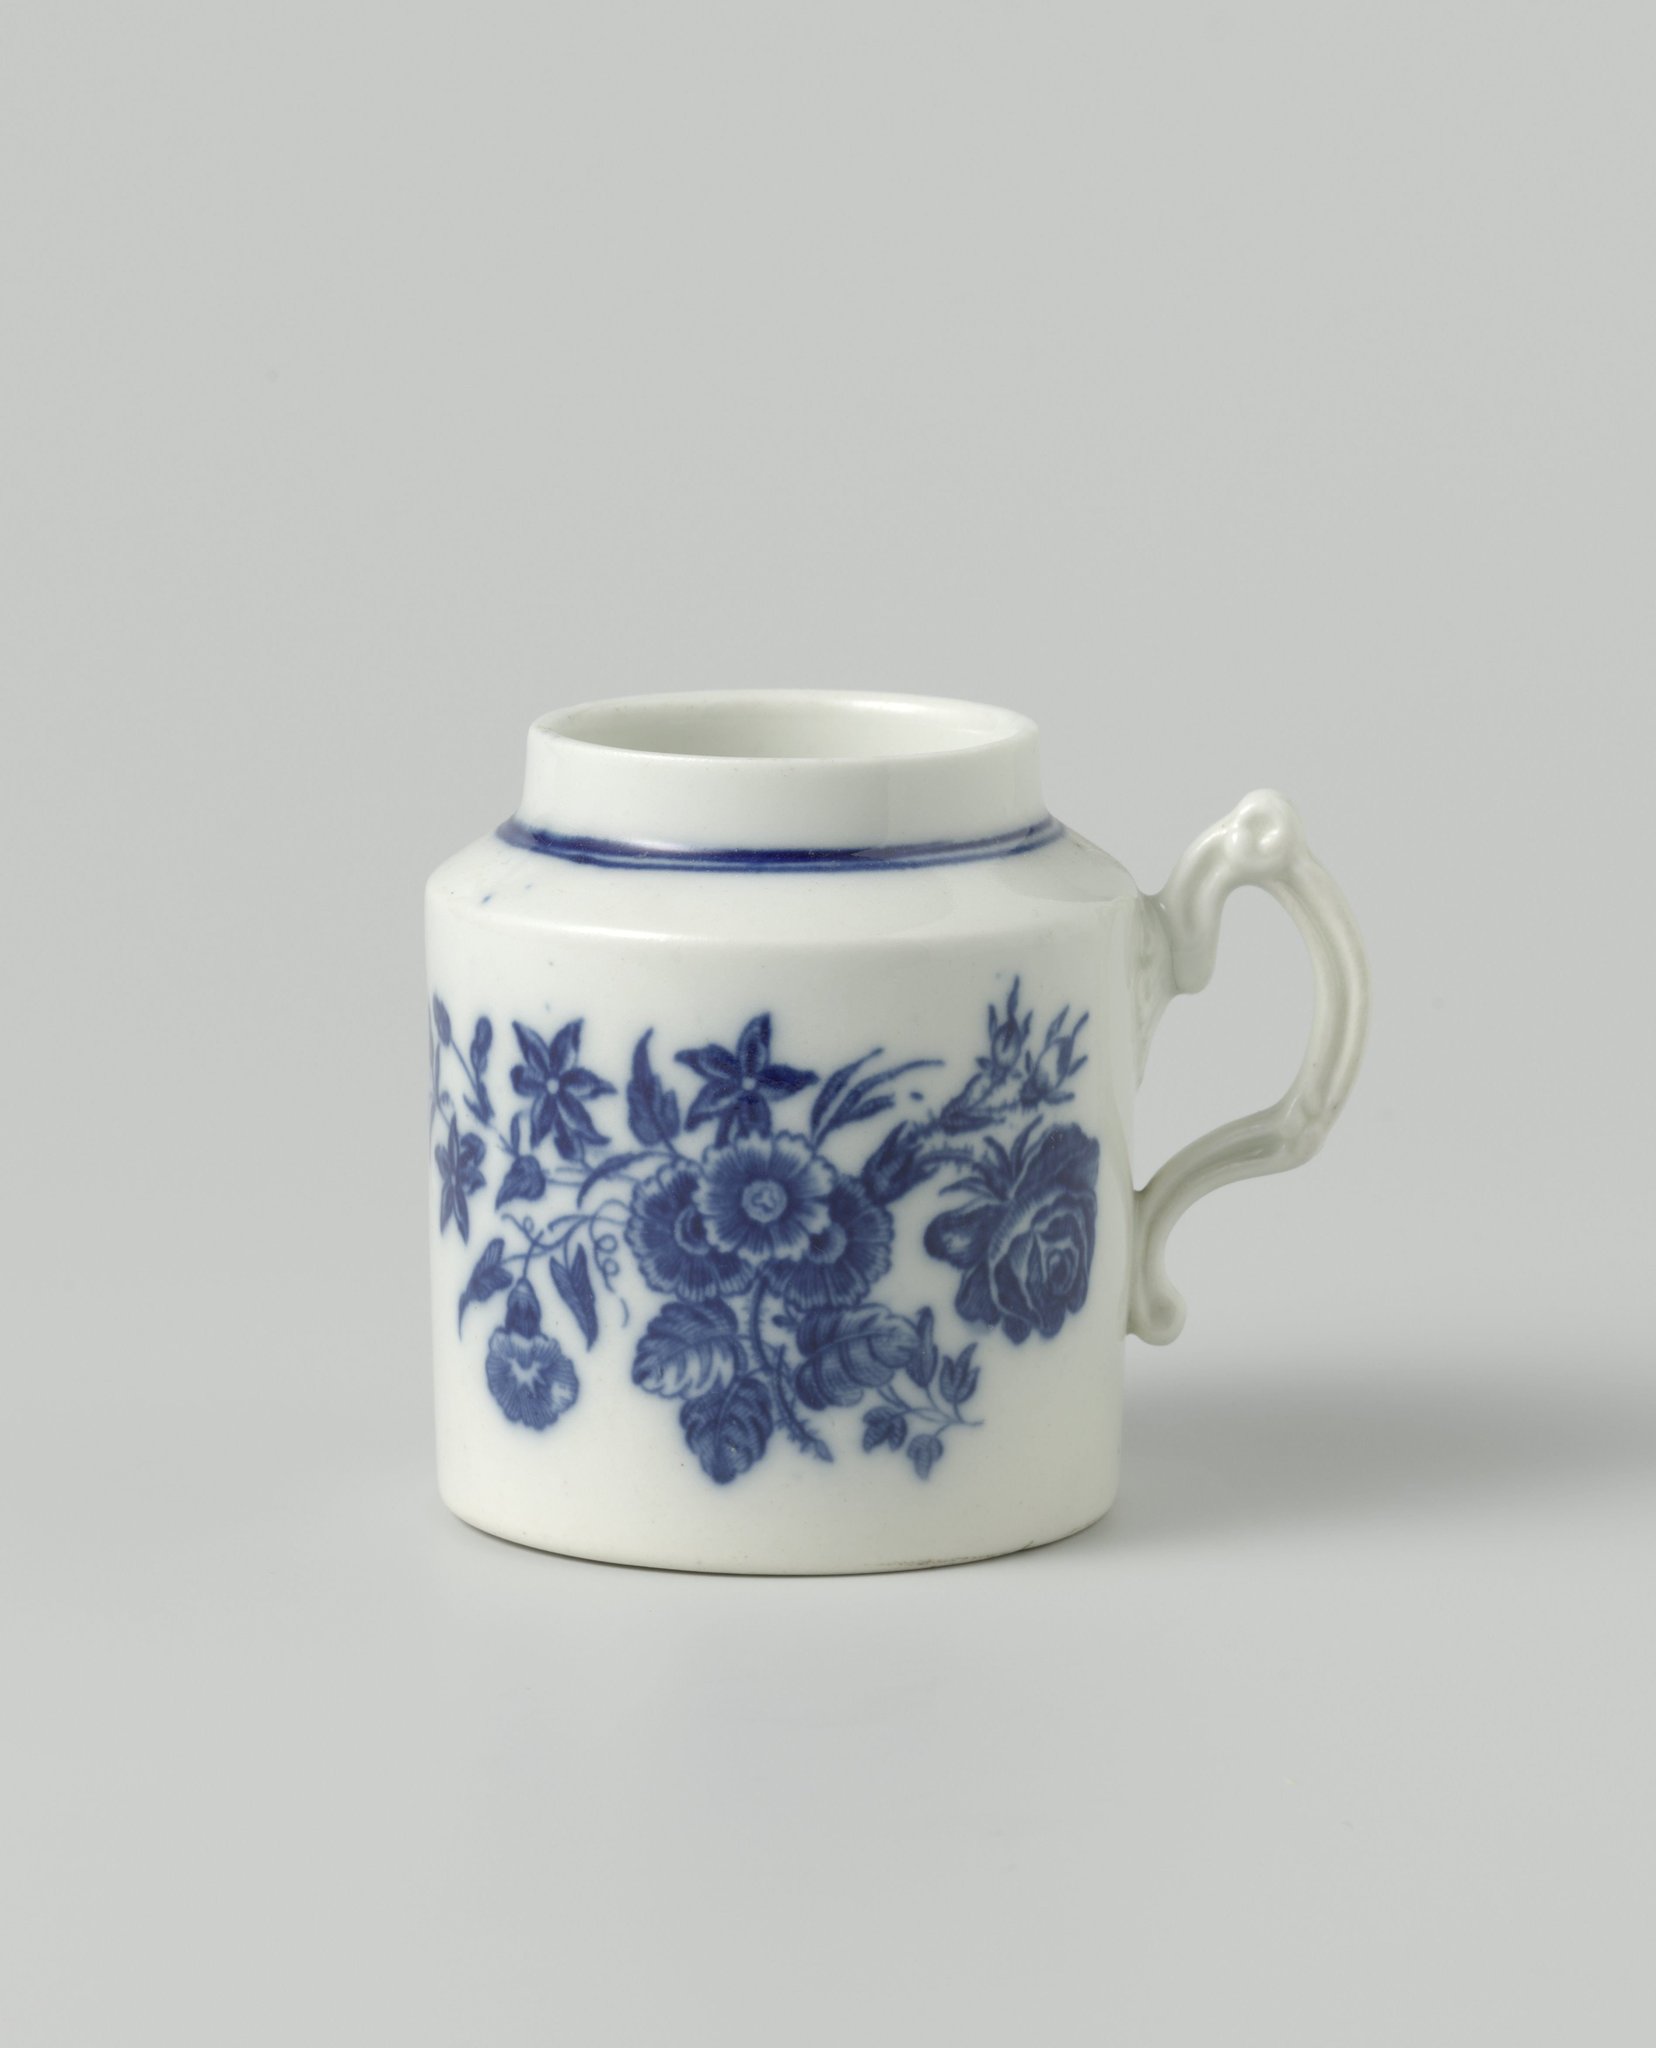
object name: vessel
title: Mosterdpot met deksel en lepel met bloemdecoratie met vlinder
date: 1772-1804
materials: porcelain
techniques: stenciling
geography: langley mill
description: Mosterdpot met deksel en lepel van porselein. De ronde pot heeft een wit rocaille oor en is versierd met geschabloneerde bloementuilen en een vlinder. Boven aan de rand twee concentrische cirkellijnen. Het deksel is versierd met een bloemenrank en is afgezet met concentrische cirkels. Dekselknop in de vorm van een bloem met bladeren. De pot heeft een uitsparing voor de niet bij de pot behorende lepel. Lepel met groene verf versierd. Gemerkt: L van Langkley.